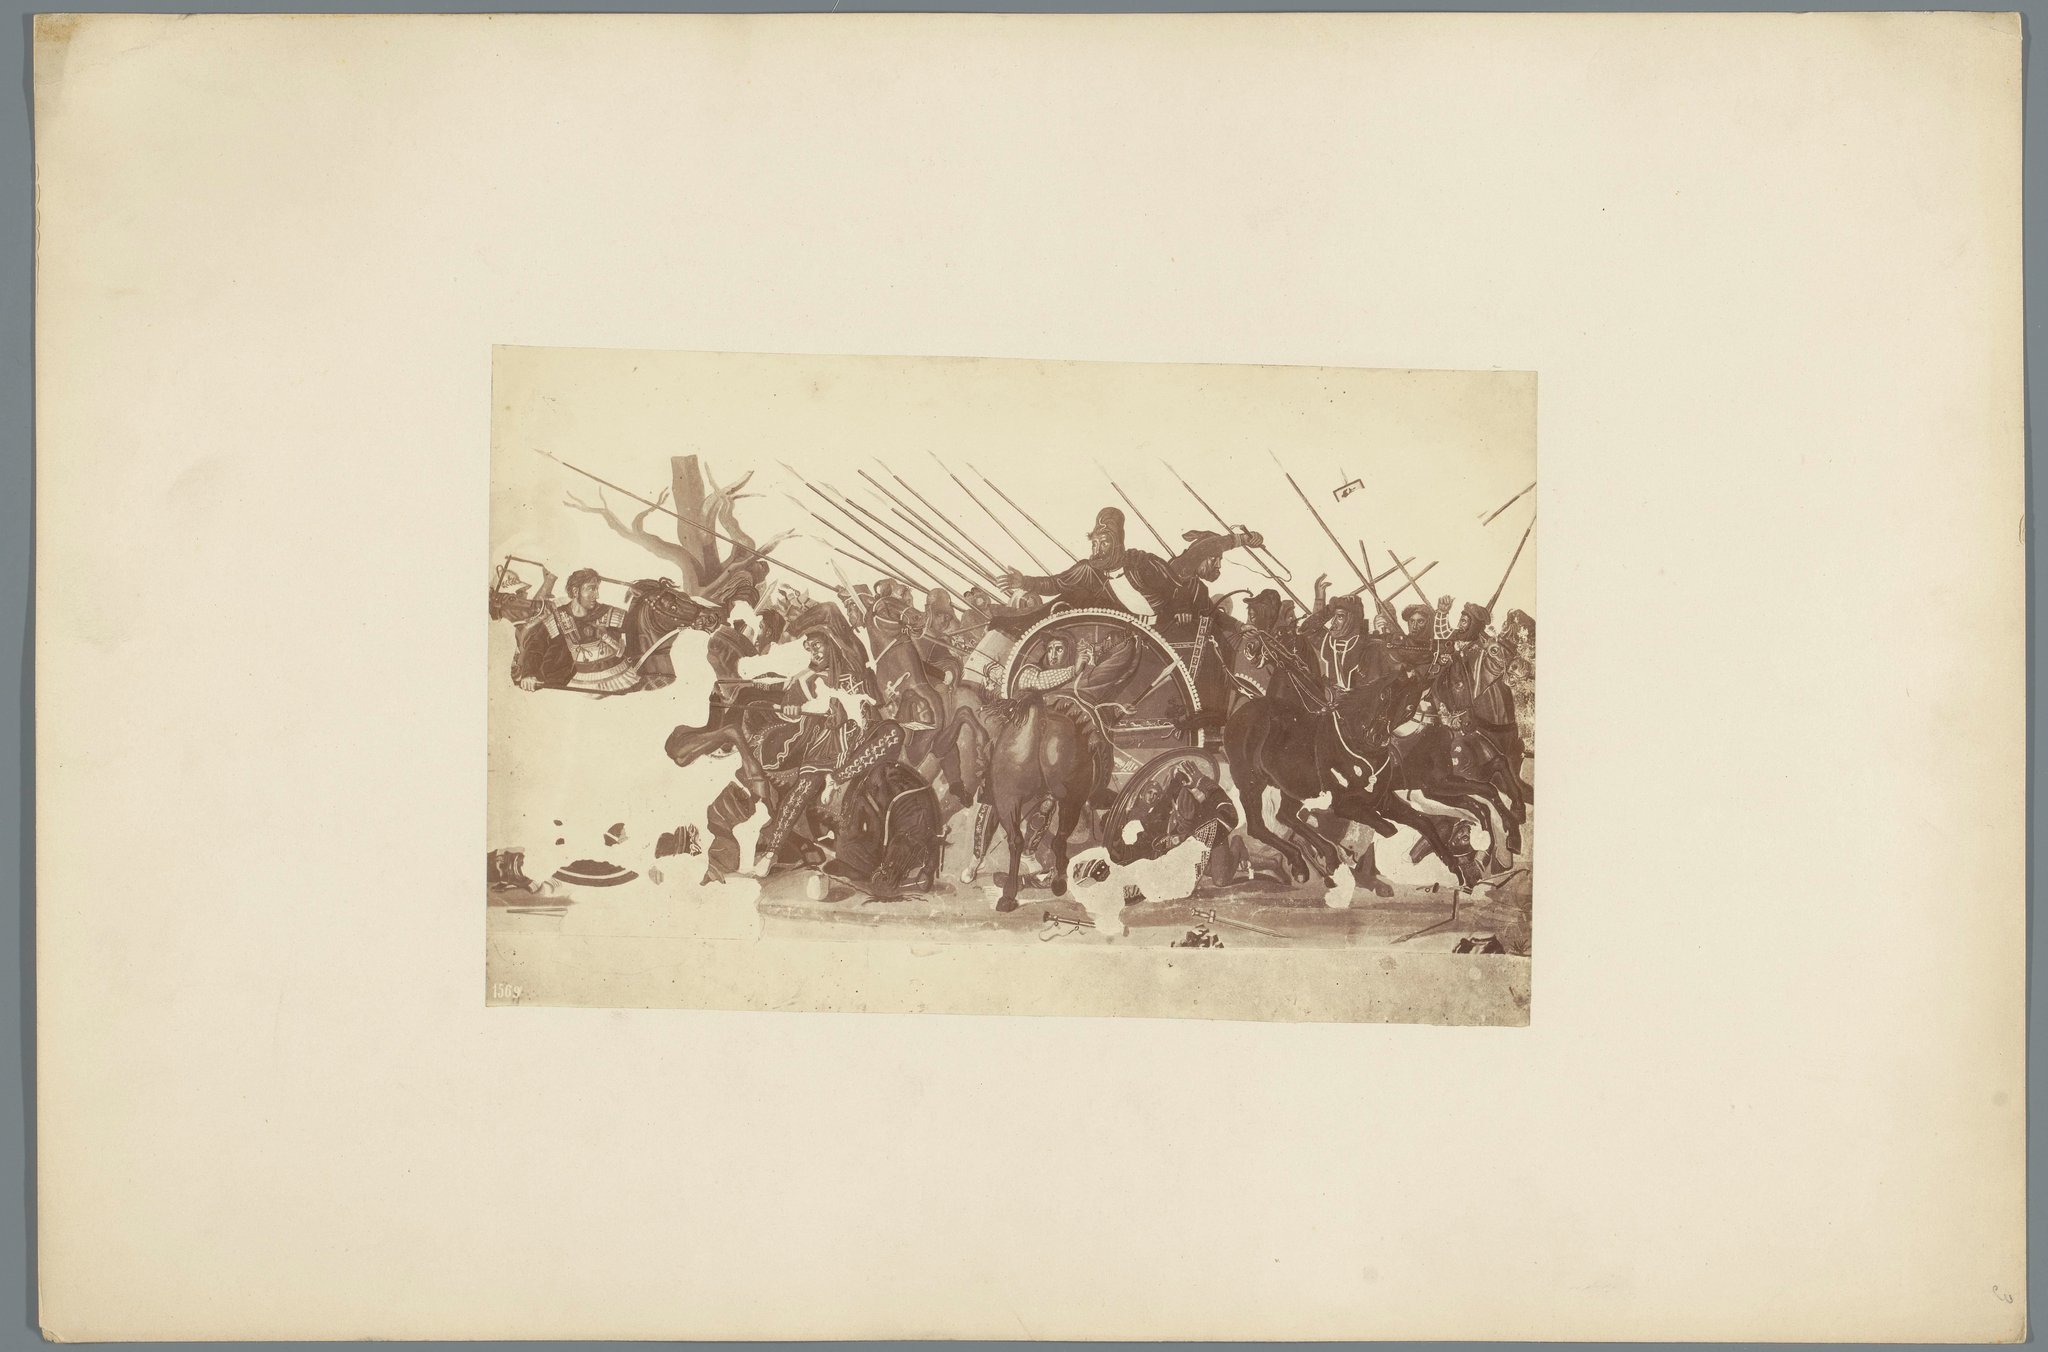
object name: photograph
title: Fotoreproductie van een schildering voorstellend een man op een strijdwagen met daar omheen mannen met speren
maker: Anonymous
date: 1875-1900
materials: cardboard, photographic support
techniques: albumen print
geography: europe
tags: painting (including book-illumination, miniature-painting) (+ plaster ~ arts), ancient forms of military vehicles: chariot, battle wagon, etc., casting weapons: spear, europe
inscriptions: collector's mark: Lugt 3937, number: ‘1569’